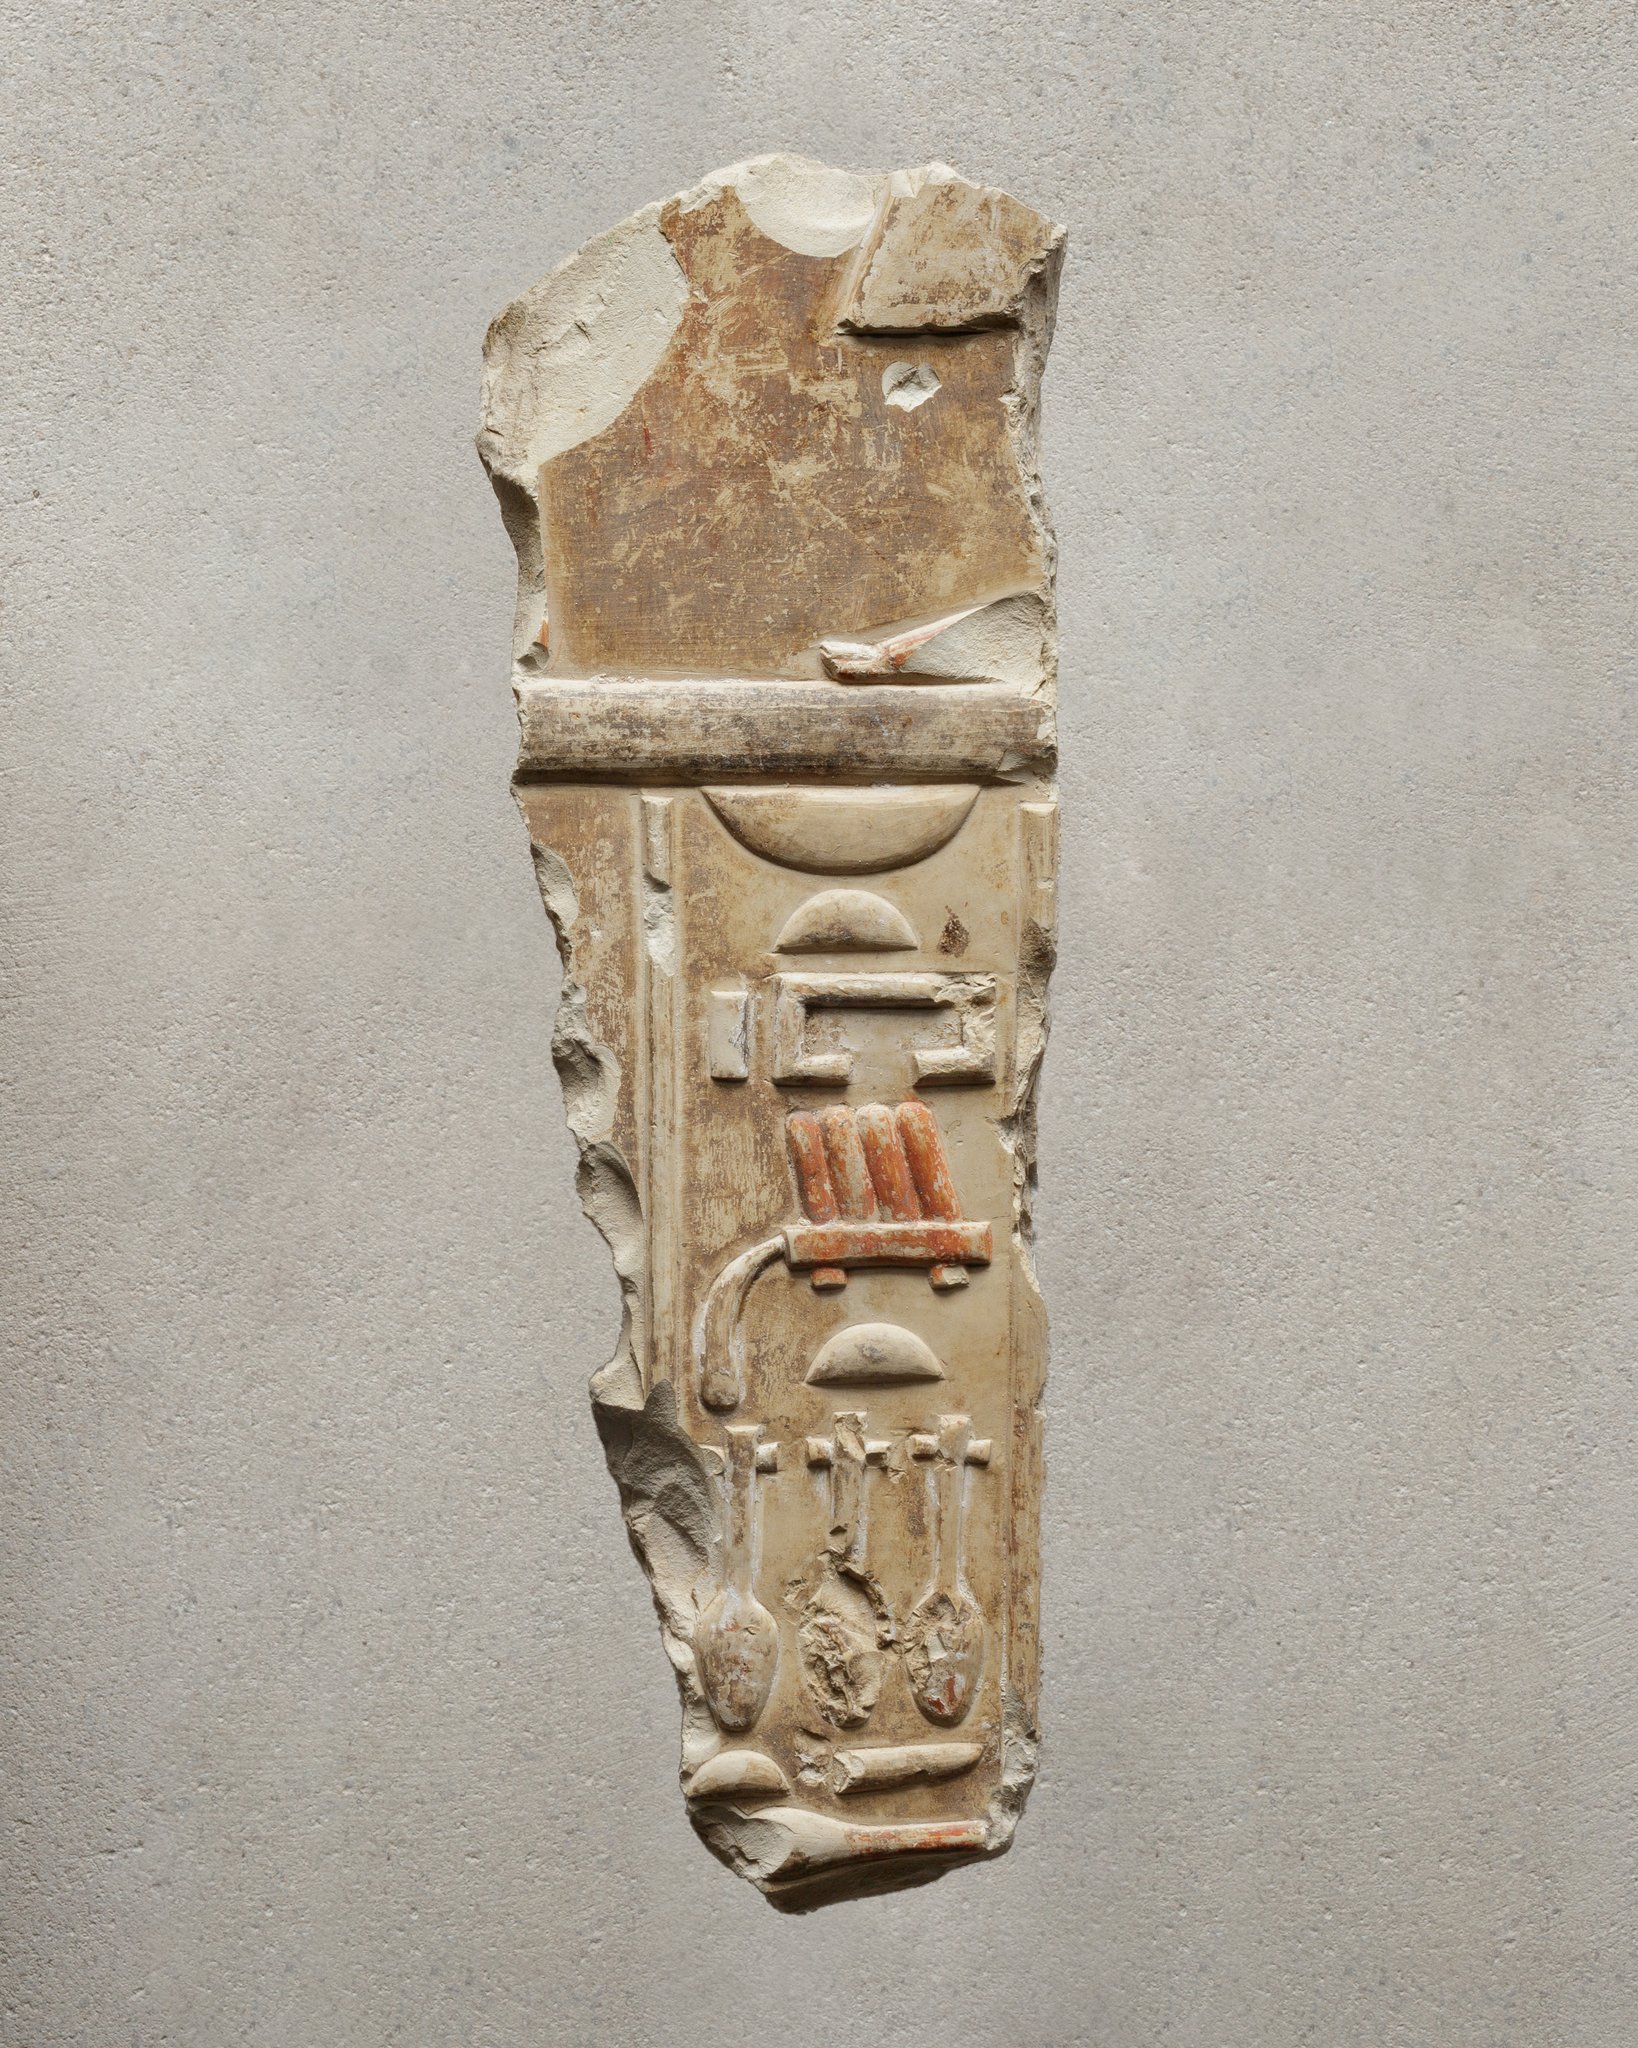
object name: relief, female attendant, neferu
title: Fragment from scene of Queen Neferu having her hair done - see 26.3.353-5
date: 2051-2030 BCE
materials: limestone, paint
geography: egypt